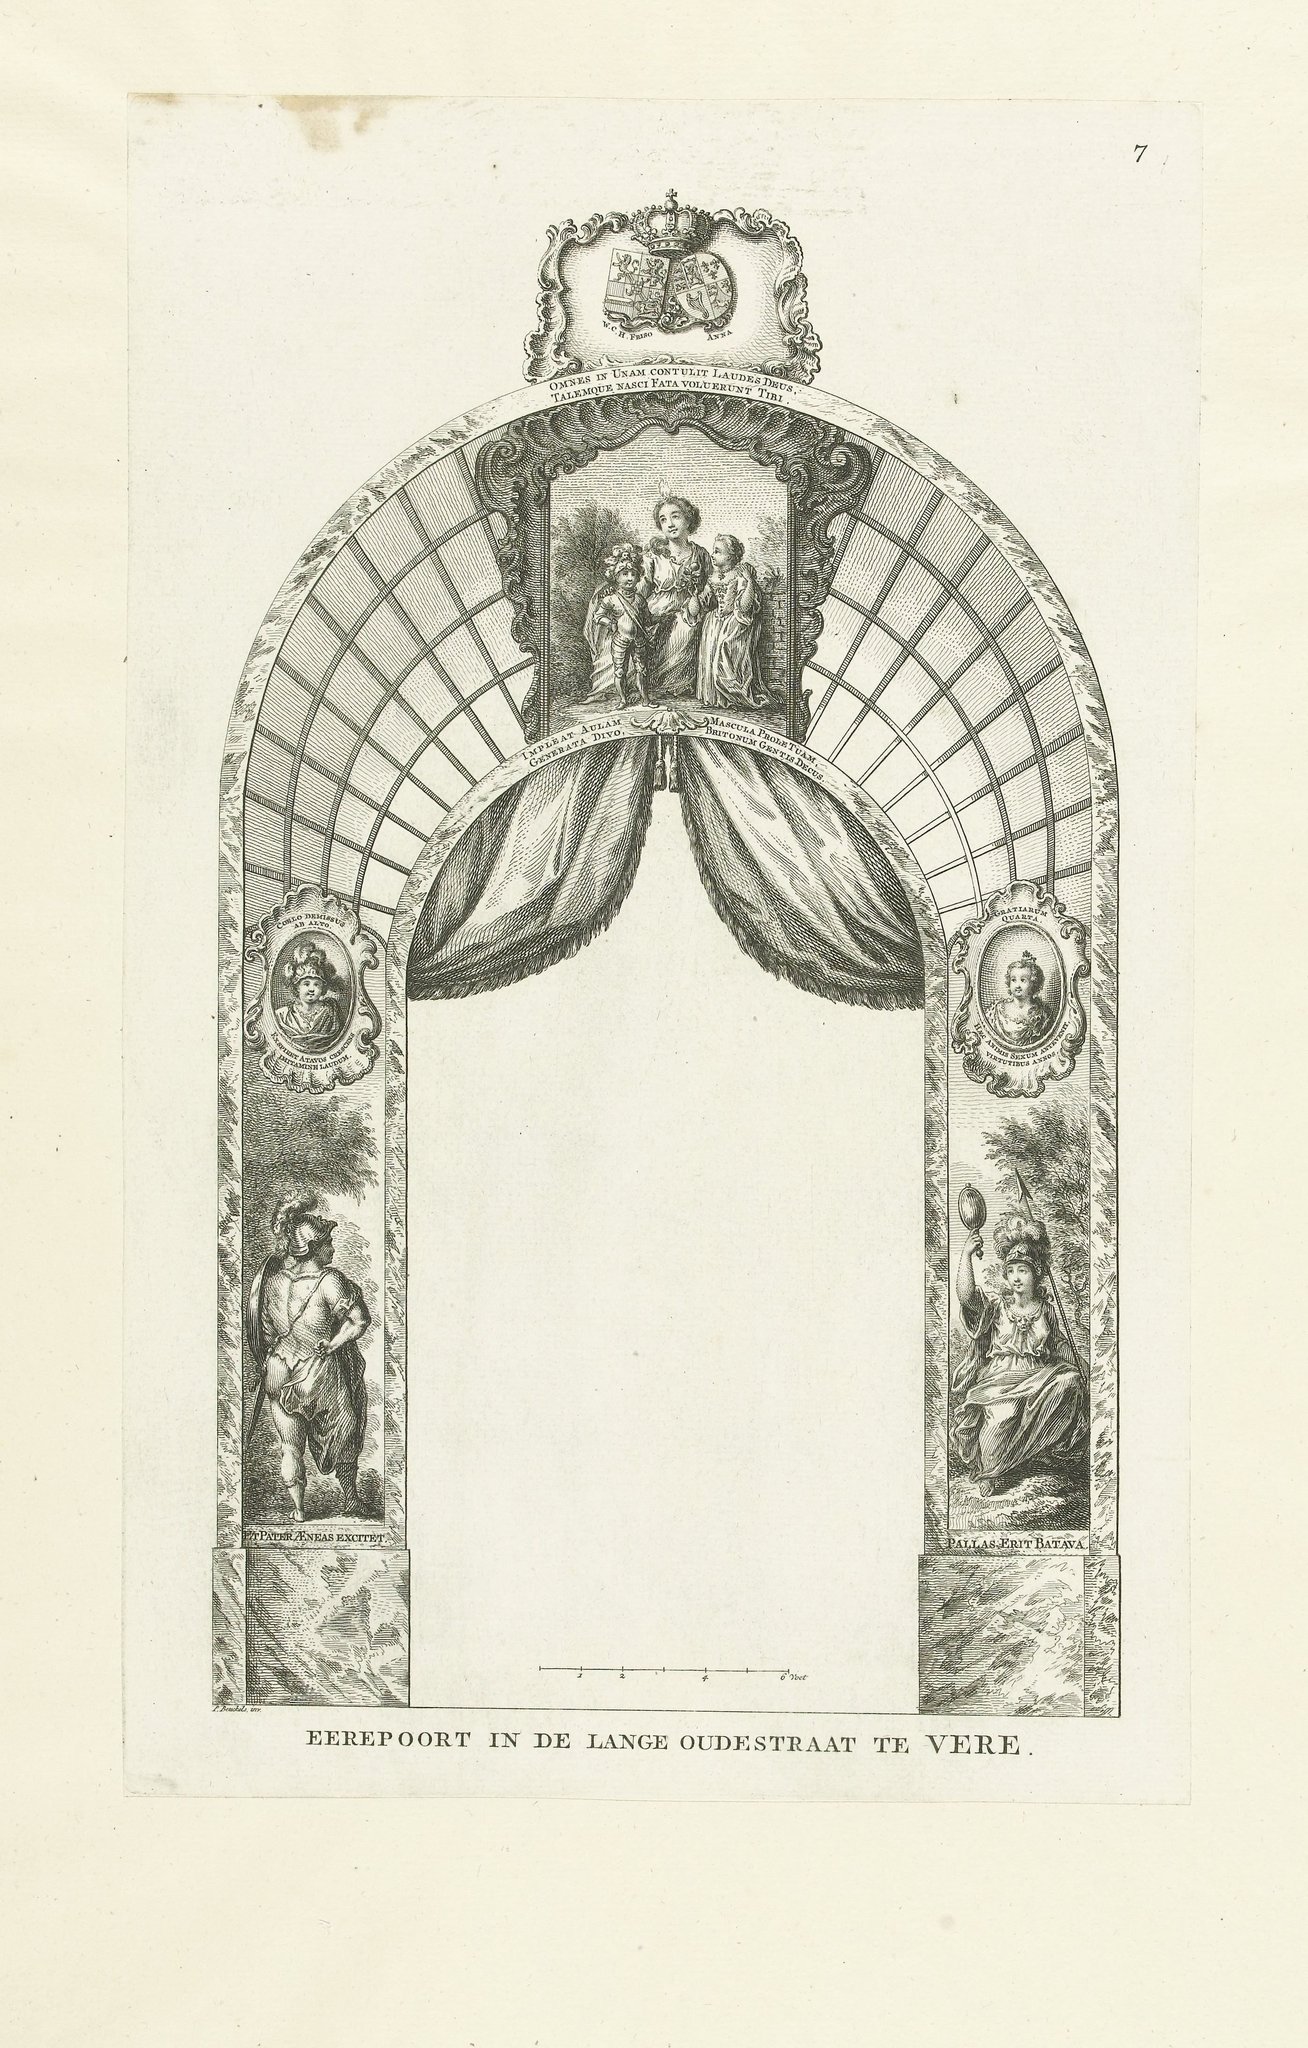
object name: print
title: Eerepoort in de Lange Oudestraat te Vere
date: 1751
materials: paper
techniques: engraving, etching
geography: veere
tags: william v (prince of orange), carolina (prinses van oranje-nassau), willem iv (prins van oranje-nassau), the hague, anna van hannover, triumphal arch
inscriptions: collector's mark: Lugt 2228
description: De erepoort geplaatst in de Lange Oudestraat. Op de boog portretten van Anna van Hannover en de kinderen prins Willem V en prinses Carolina. Onderdeel van de illustraties van de feestelijke inhuldiging van stadhouder Willem IV als markgraaf van Veere op 1 juni 1751. Genummerd rechtsboven: 7.